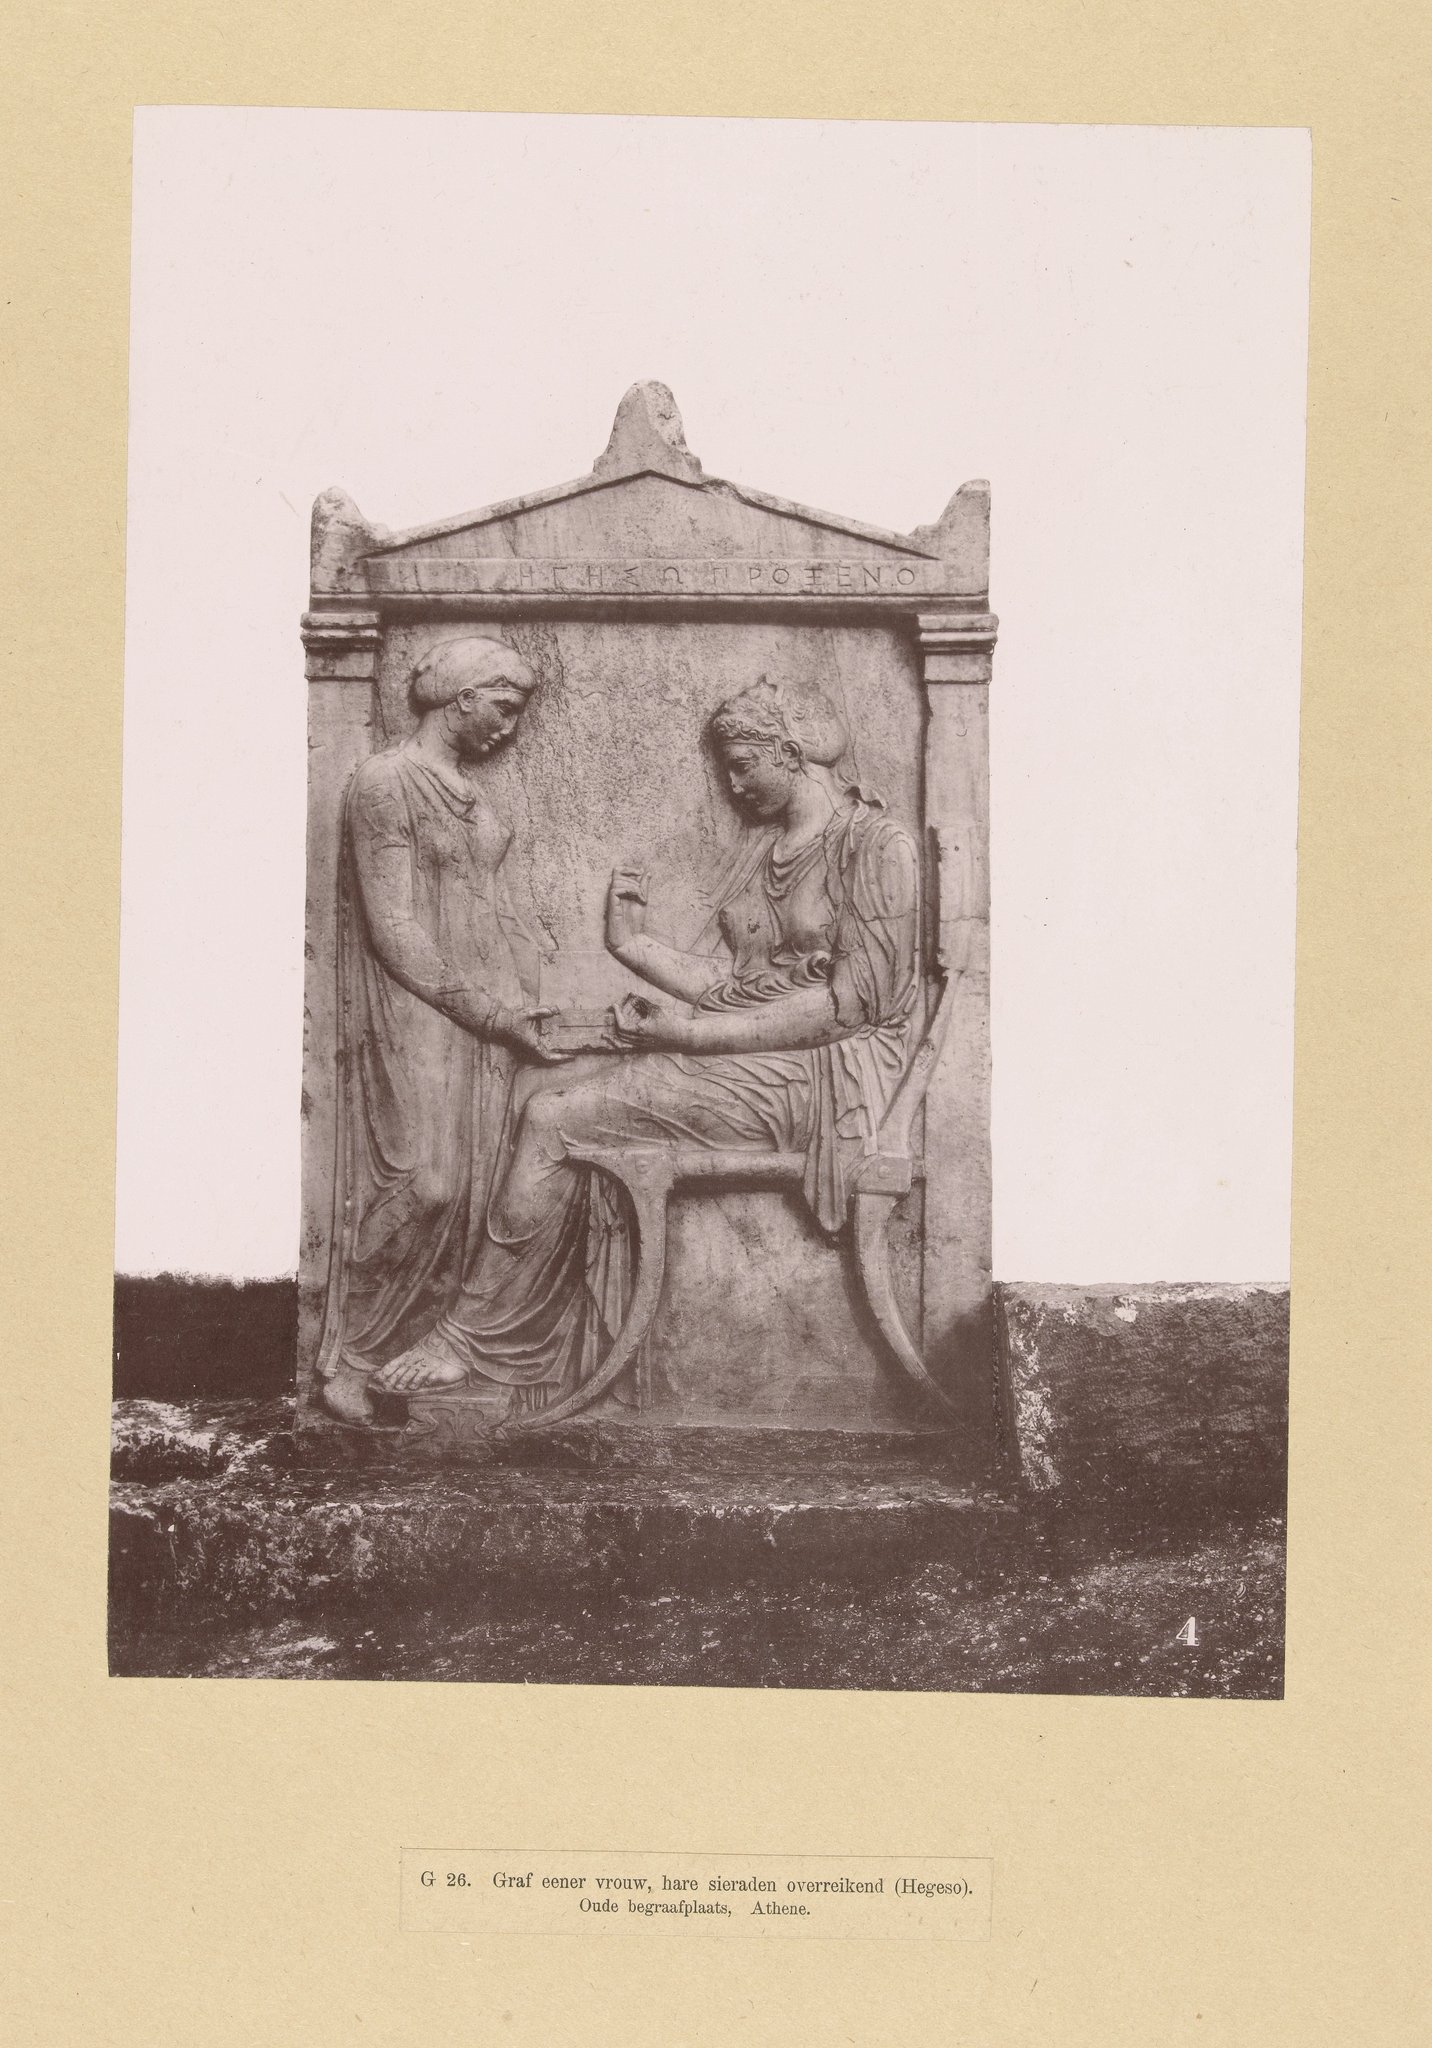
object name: photomechanical print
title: G 26. Graf eener vrouw, hare sieraden overreikend (Hegeso). Oude begraafplaats, Athene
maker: Anonymous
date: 1890-1893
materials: cardboard, paper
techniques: photograph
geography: athens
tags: piece of sculpture, reproduction of a piece of sculpture, gravestone, tombstone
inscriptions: stamp: ‘Gemeentelijke bibliotheek/ Rotterdam’, check stamp: ‘Bristol/ L.M.’, title: ‘G 26. Graf eener vrouw, hare sieraden overreikend (Hegeso)./ Oude begraafplaats, Athene.’, number: ‘4’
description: De overleden Hegeso, dochter van Proxenos, staat haar sieraden af aan haar bediende. Onderdeel van een groep door fotograaf Richard Polak op reis verzamelde foto’s. Deze fotomechanische afdruk is samen met andere op zijn reizen verzamelde foto's tentoongesteld bij de Rotterdamsche Kunstkring (1895), Arti en Amicitiae te Amsterdam (1897-1898?) en Societeit 't Collegie te Kampen (datum vooralsnog onbekend).